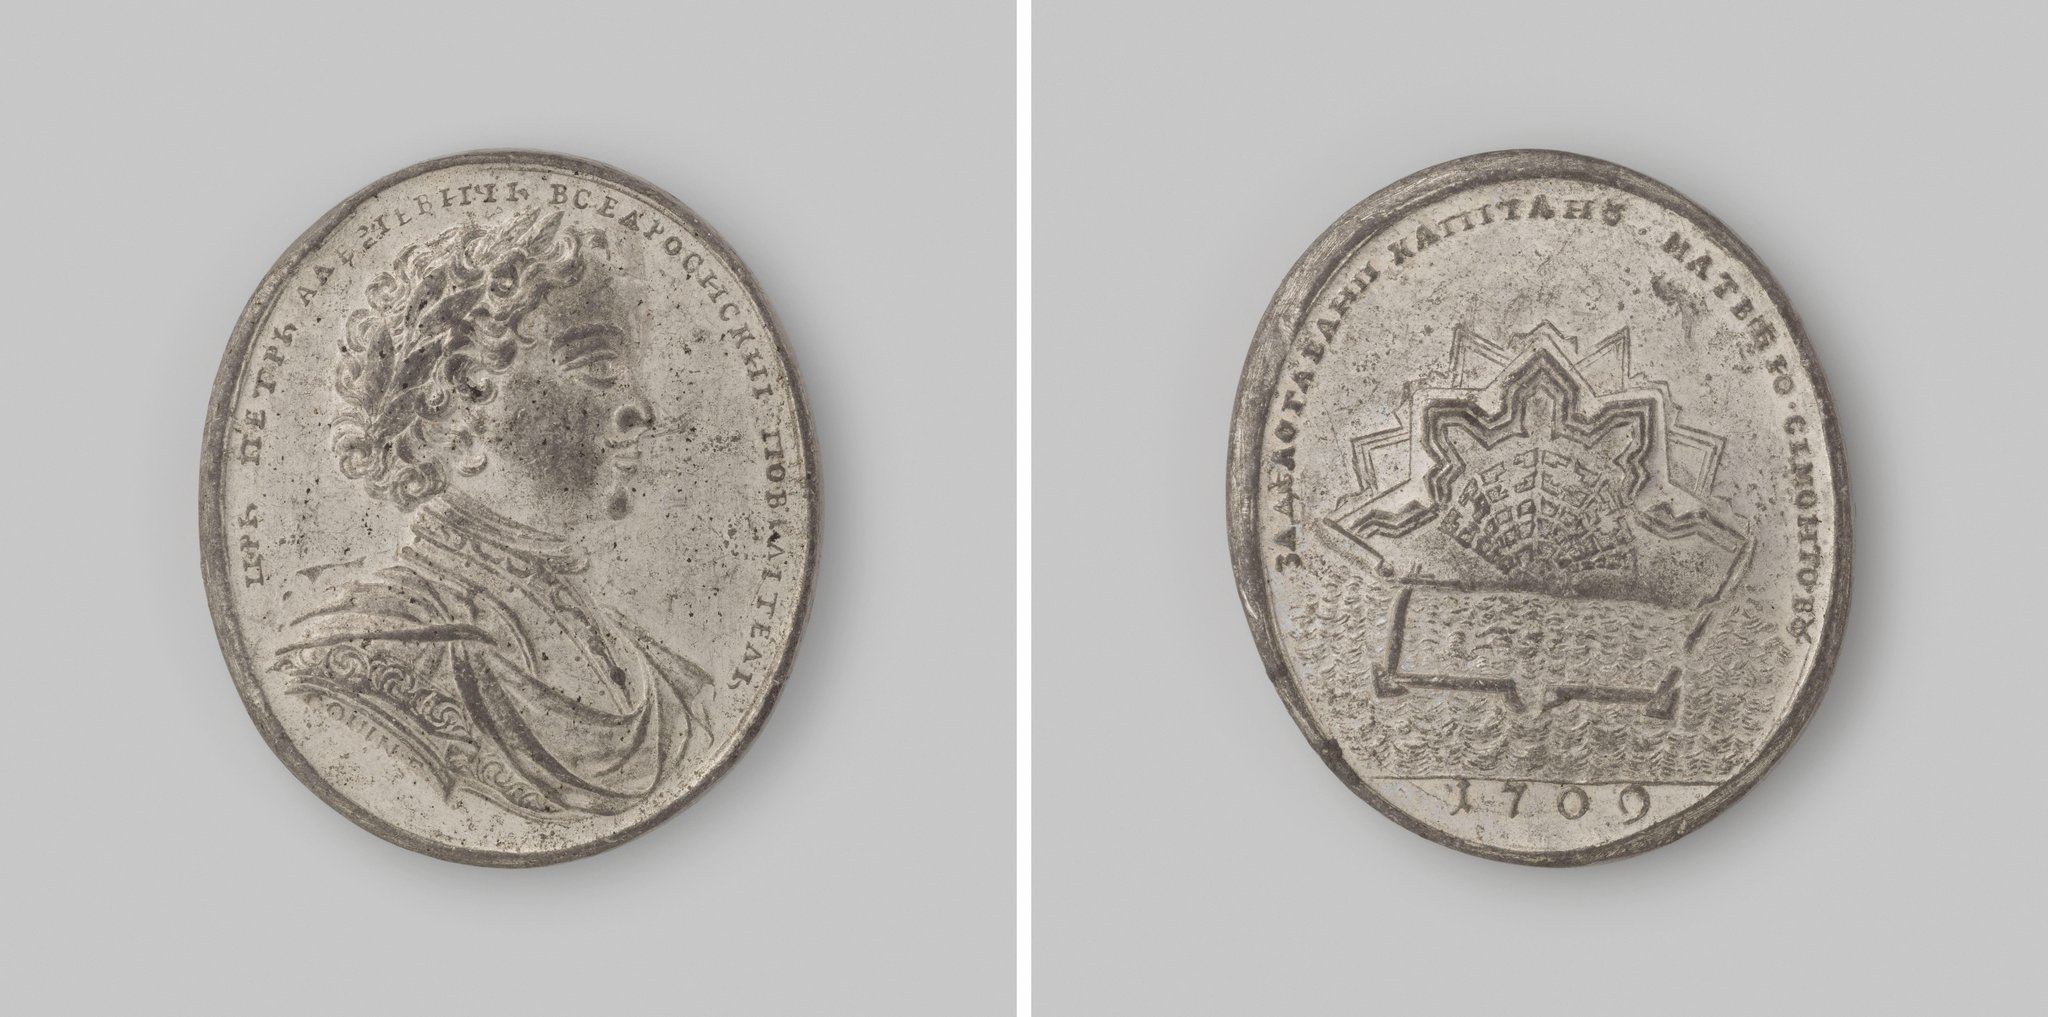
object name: history medal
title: Aanleg van de haven van Taganrog door Mathieu Simontof 1709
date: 1709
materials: tin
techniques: striking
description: Ovalen tinnen penning, op de voorzijde het borstbeeld van Tsaar Peter de Grote naar rechts met omschrift, op de keerzijde de plattegrond van het fort en de haven van Taganrog met omschrift en afsnedetekst.